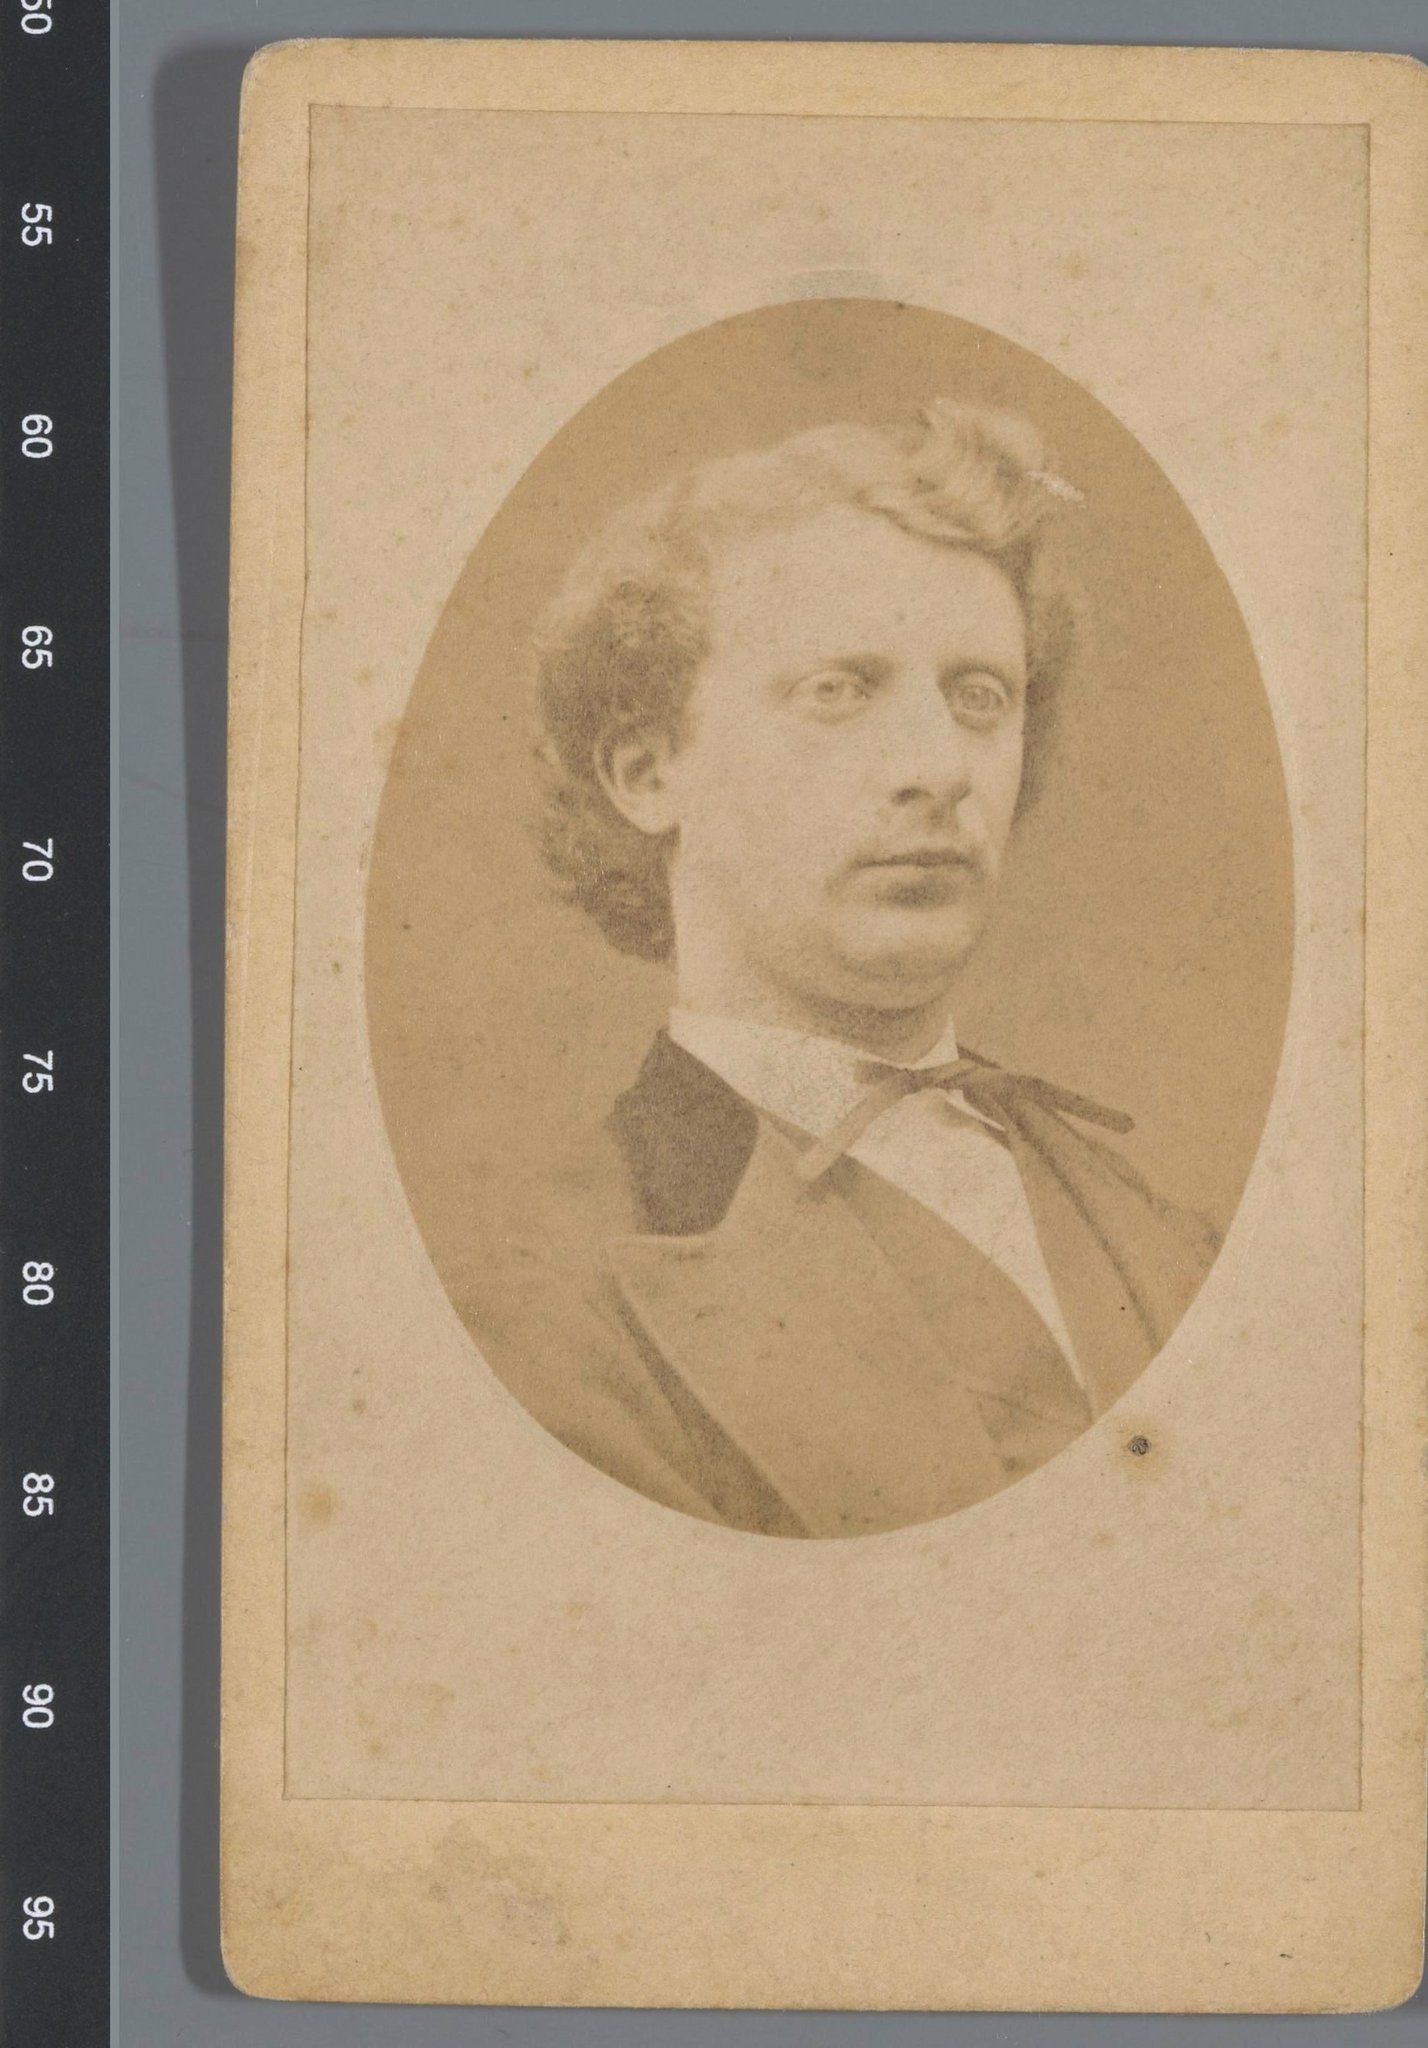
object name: photograph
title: Portret van een onbekende man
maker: dirk engel (fotograaf)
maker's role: fotograaf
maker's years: 1829-1888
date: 1852-1888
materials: cardboard, paper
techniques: albumen print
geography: zaandam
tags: adult man, historical persons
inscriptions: inscription: ‘DE/ Peintre et Photographe/ D. ENGEL/ Rozengracht No. 209./ ZAANDAM.’